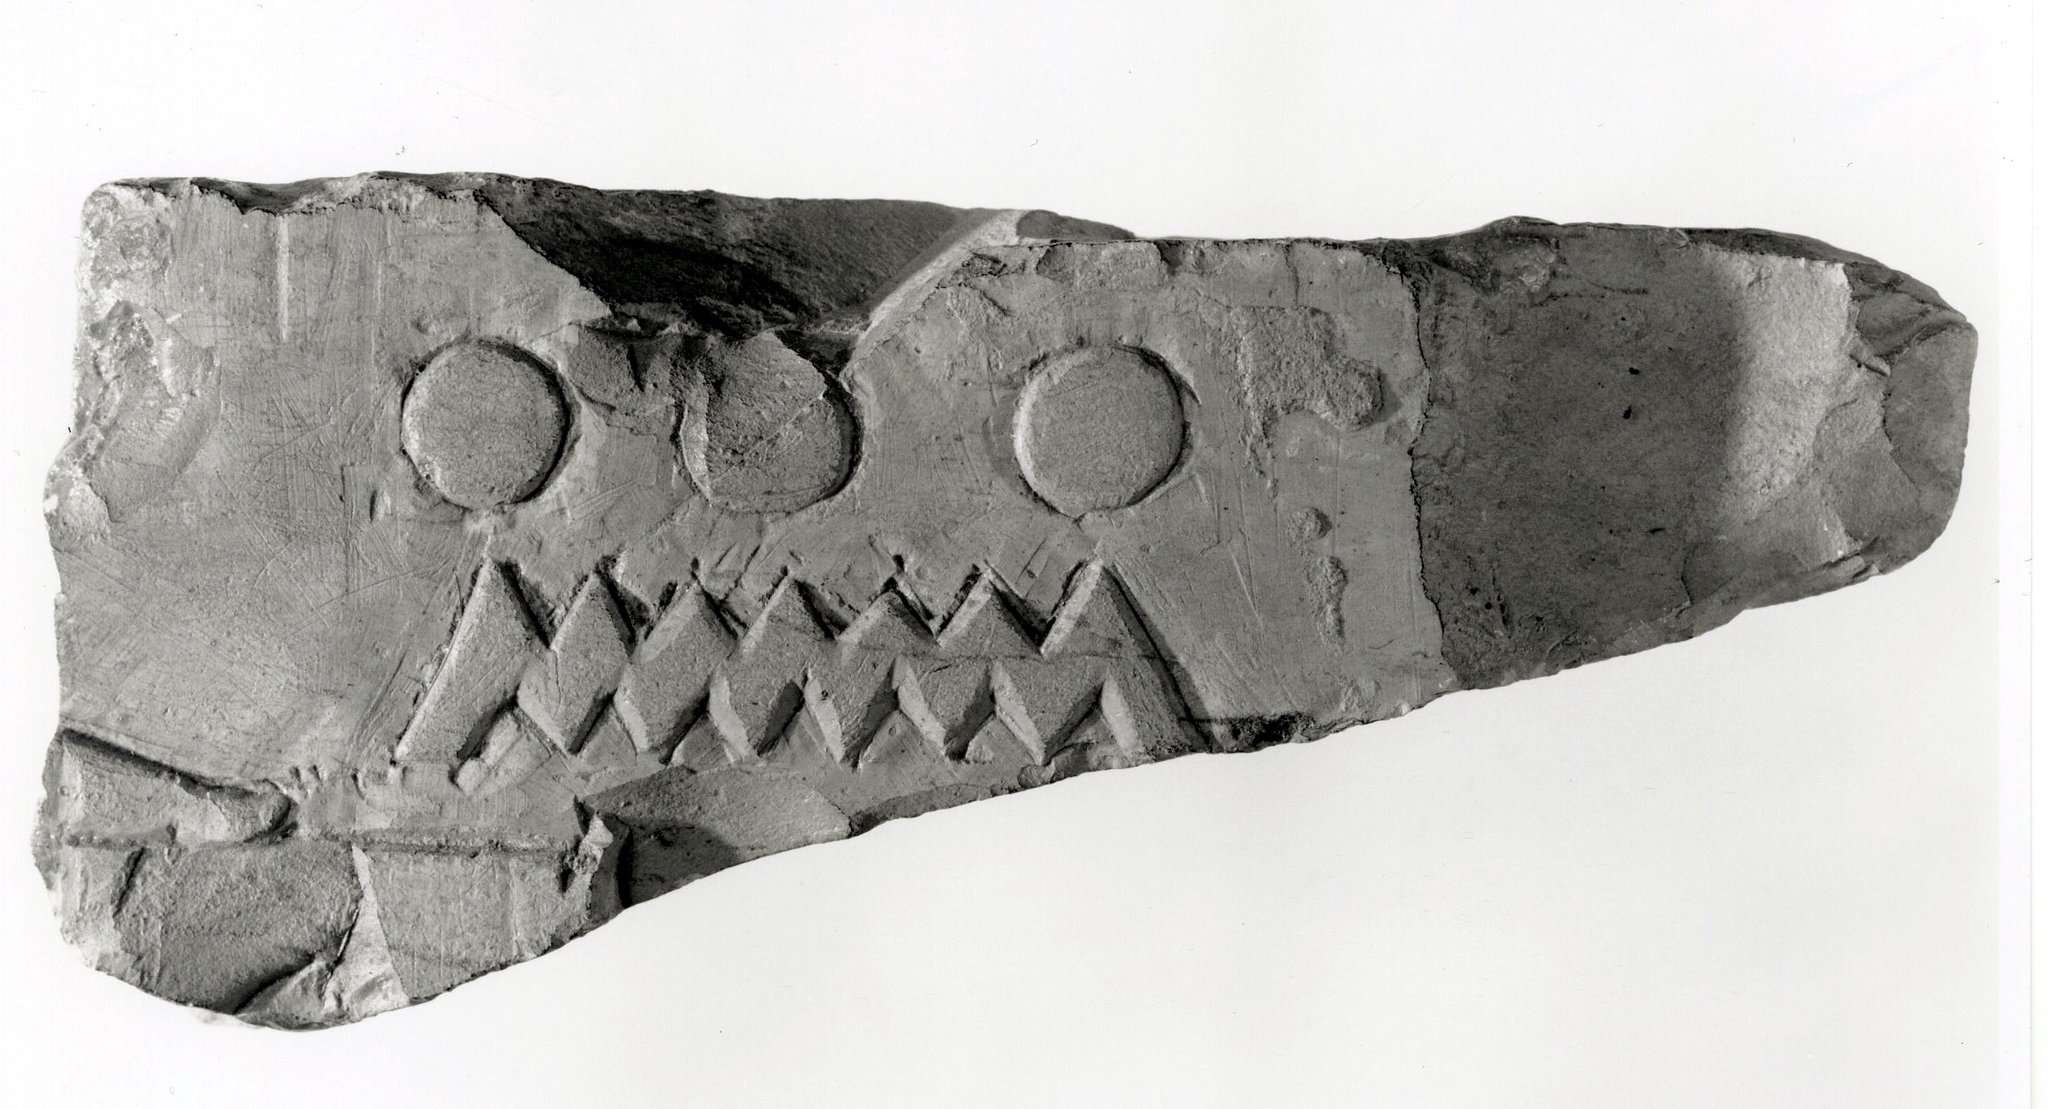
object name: relief, tomb of nespekashuty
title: Raised relief fragment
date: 664-610 BCE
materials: limestone, varnish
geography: egypt